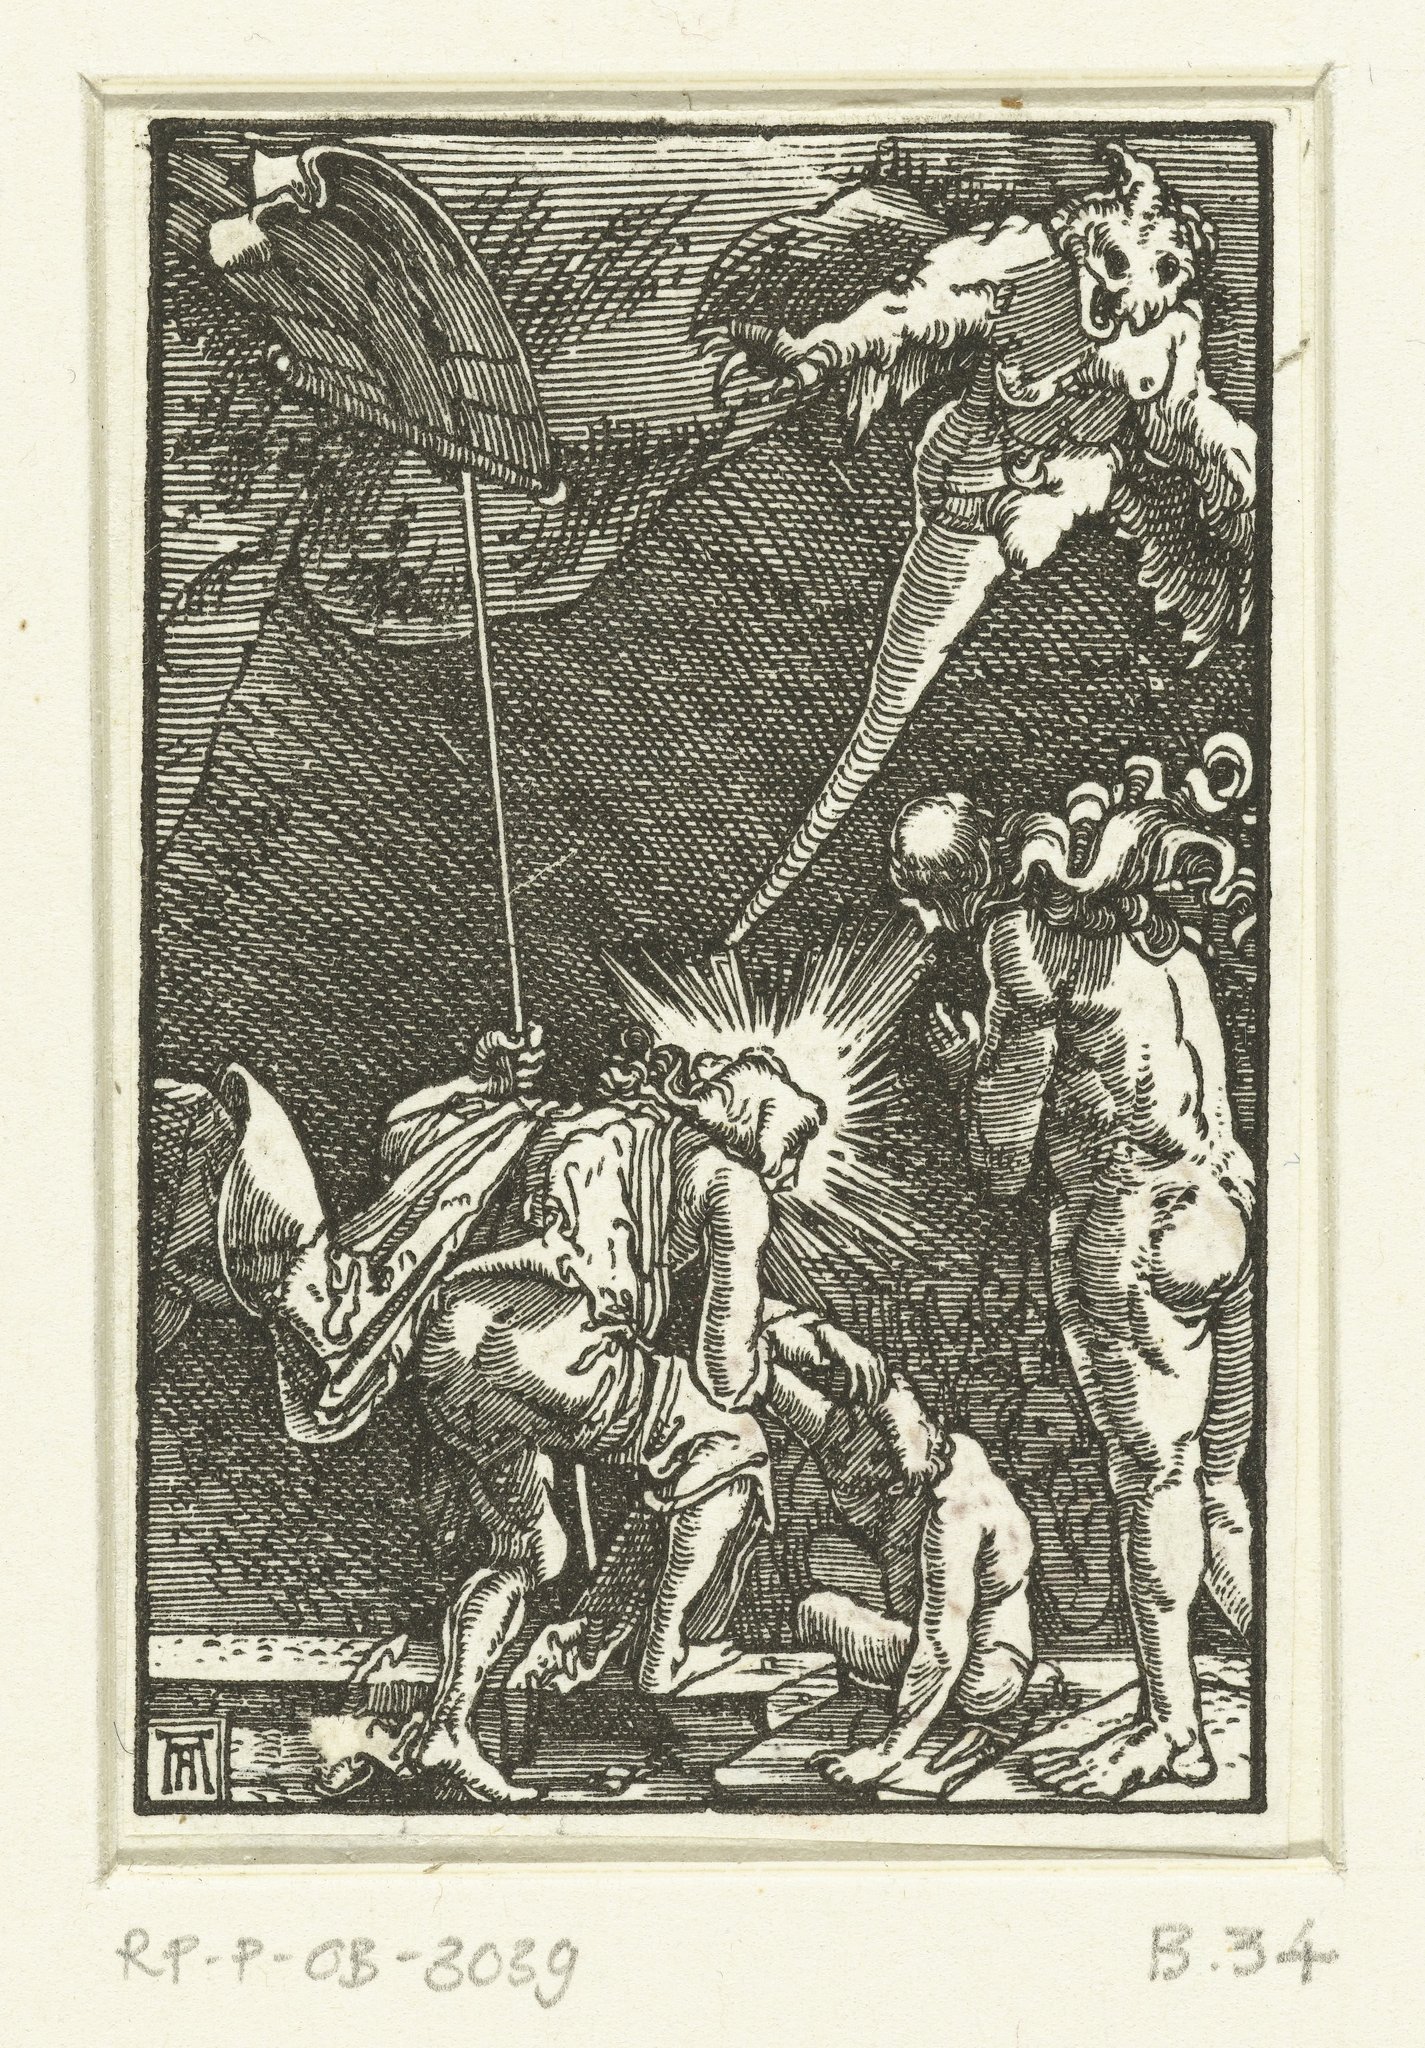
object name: print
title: Hellevaart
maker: albrecht altdorfer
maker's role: draughtsman, print maker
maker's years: 1480-1538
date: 1506-1538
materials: paper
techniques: woodcut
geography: germany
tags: christ leaving hell: he liberates patriarchs, prophets, kings and other persons from hell, among them adam, eve, moses, david, and john the baptist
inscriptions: number: ‘22,2 - 55’, collector's mark: Lugt 240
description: Christus, op de rug gezien, met een vaandel in de linkerhand, trekt Adam uit het voorgeborchte. Eva staat naast hem. Vierendertigste prent uit een serie van veertig.